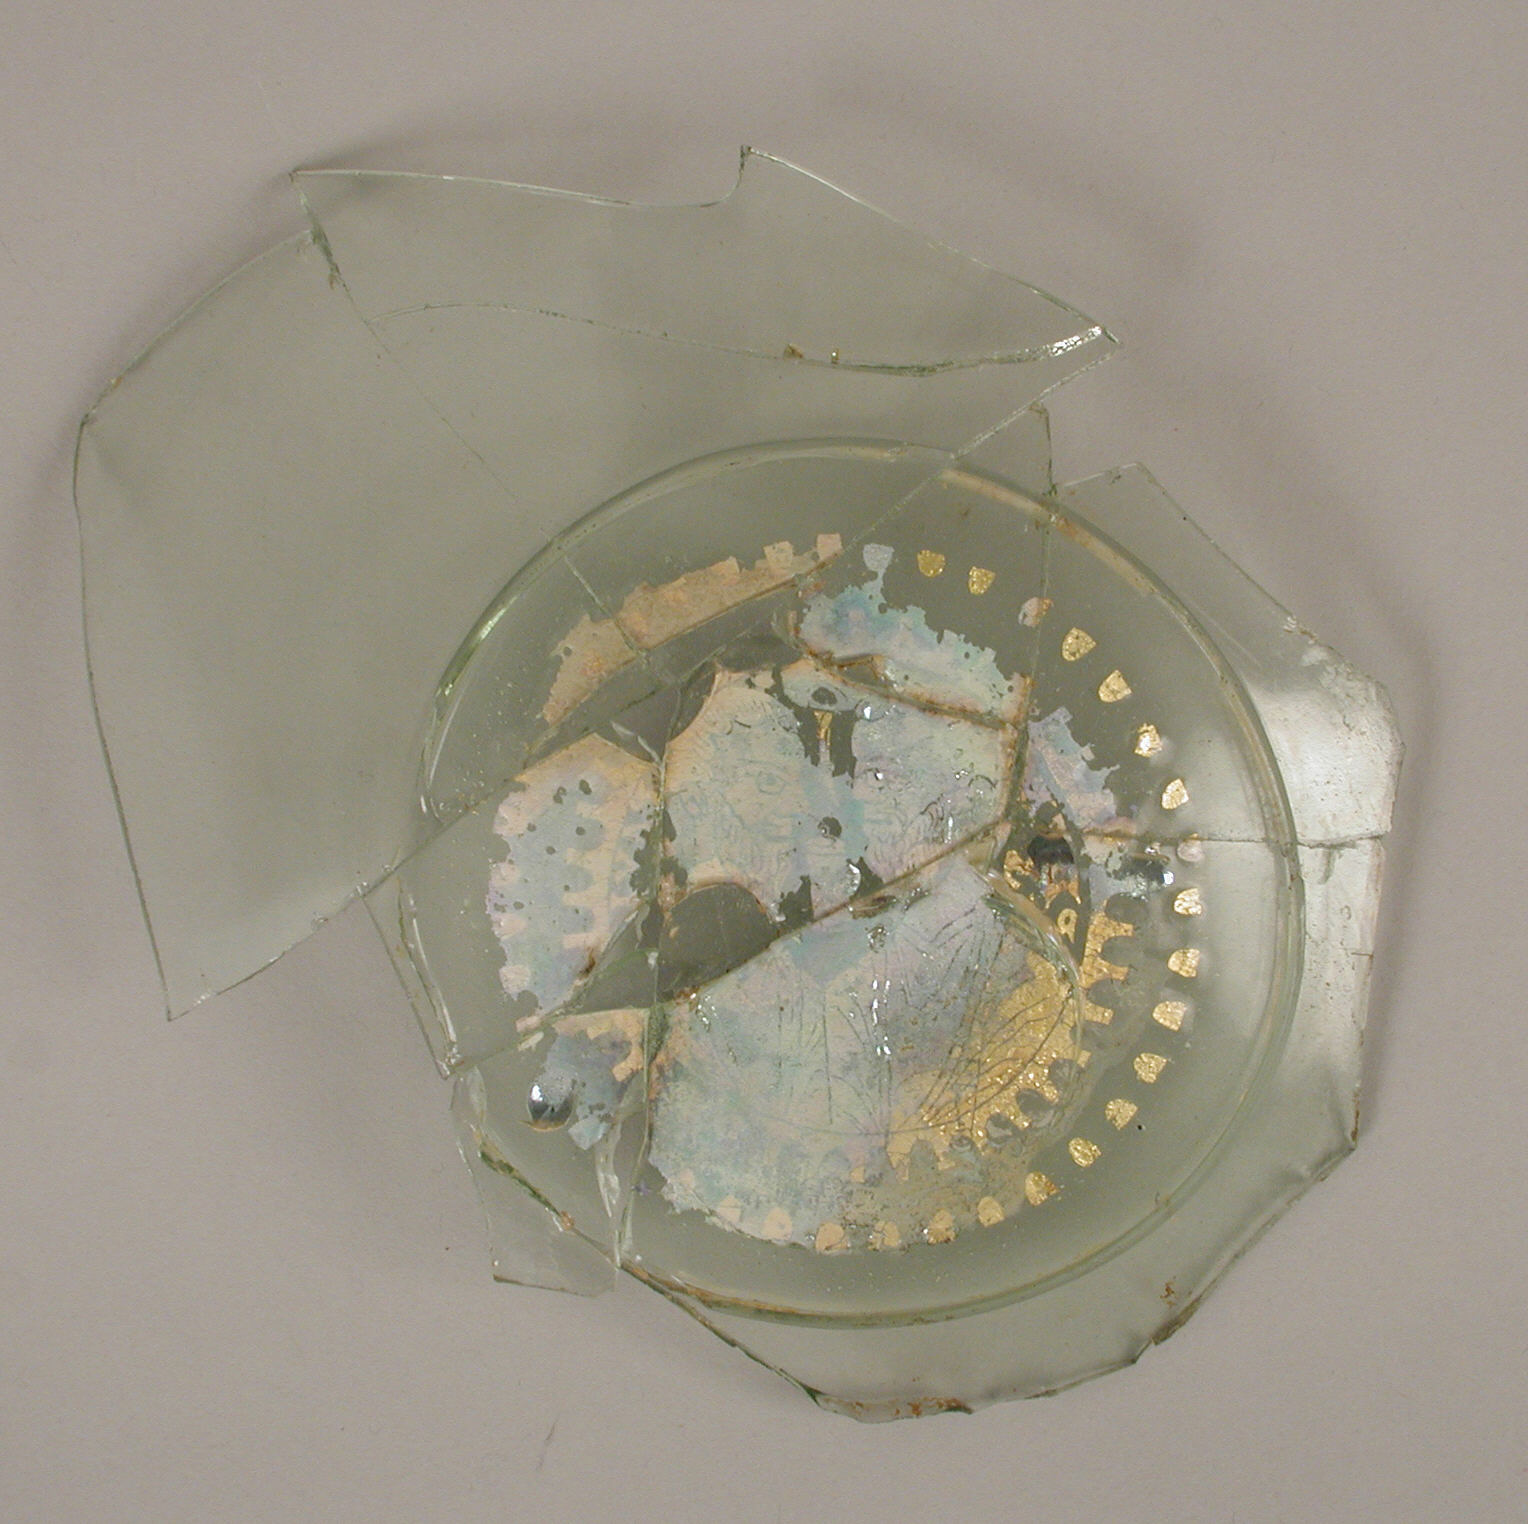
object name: bowl bottom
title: Bowl Bottom with the Busts of Two Saints (Peter and Paul?)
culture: roman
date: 367-433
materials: glass, gold leaf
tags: saints